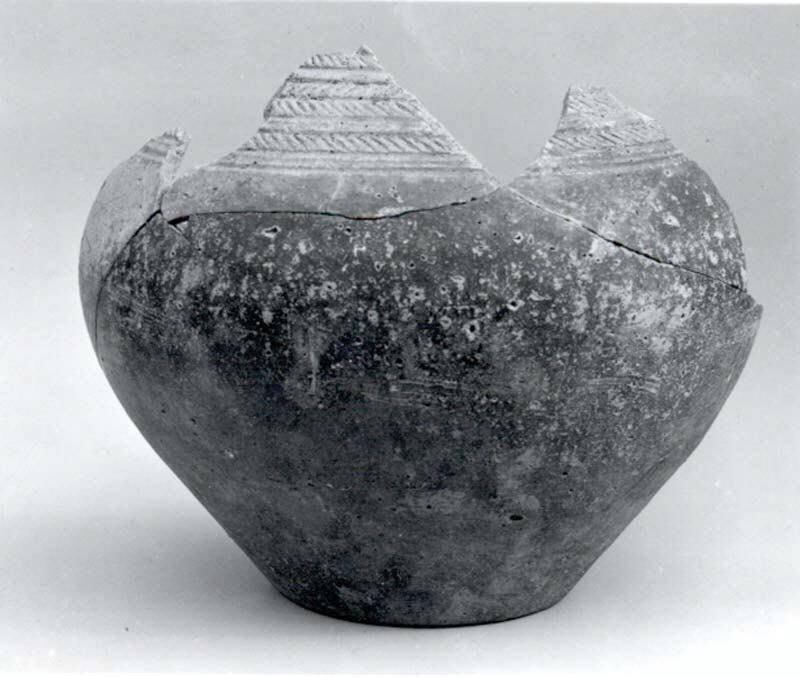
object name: jar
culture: sasanian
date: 201-700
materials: ceramic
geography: iran